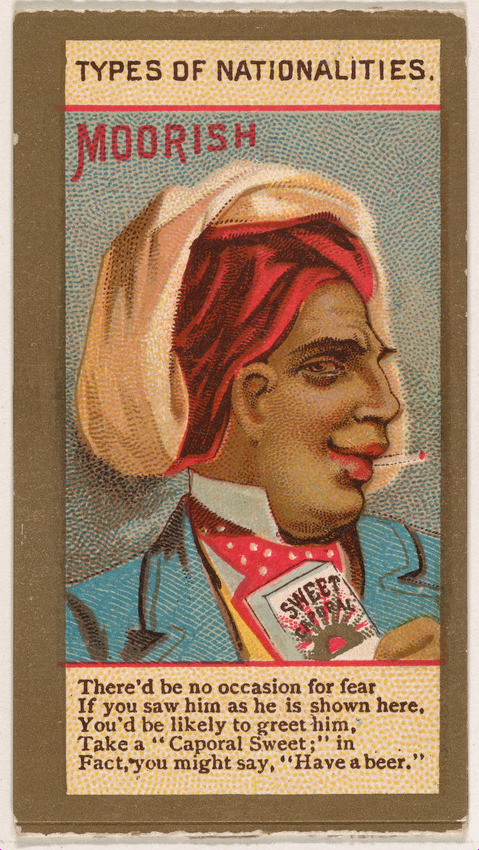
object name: print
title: Moorish, from Types of Nationalities (N240) issued by Kinney Bros.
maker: kinney brothers tobacco company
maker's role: publisher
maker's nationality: american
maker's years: 1869-2011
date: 1890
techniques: color lithograph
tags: men,profiles,smoking